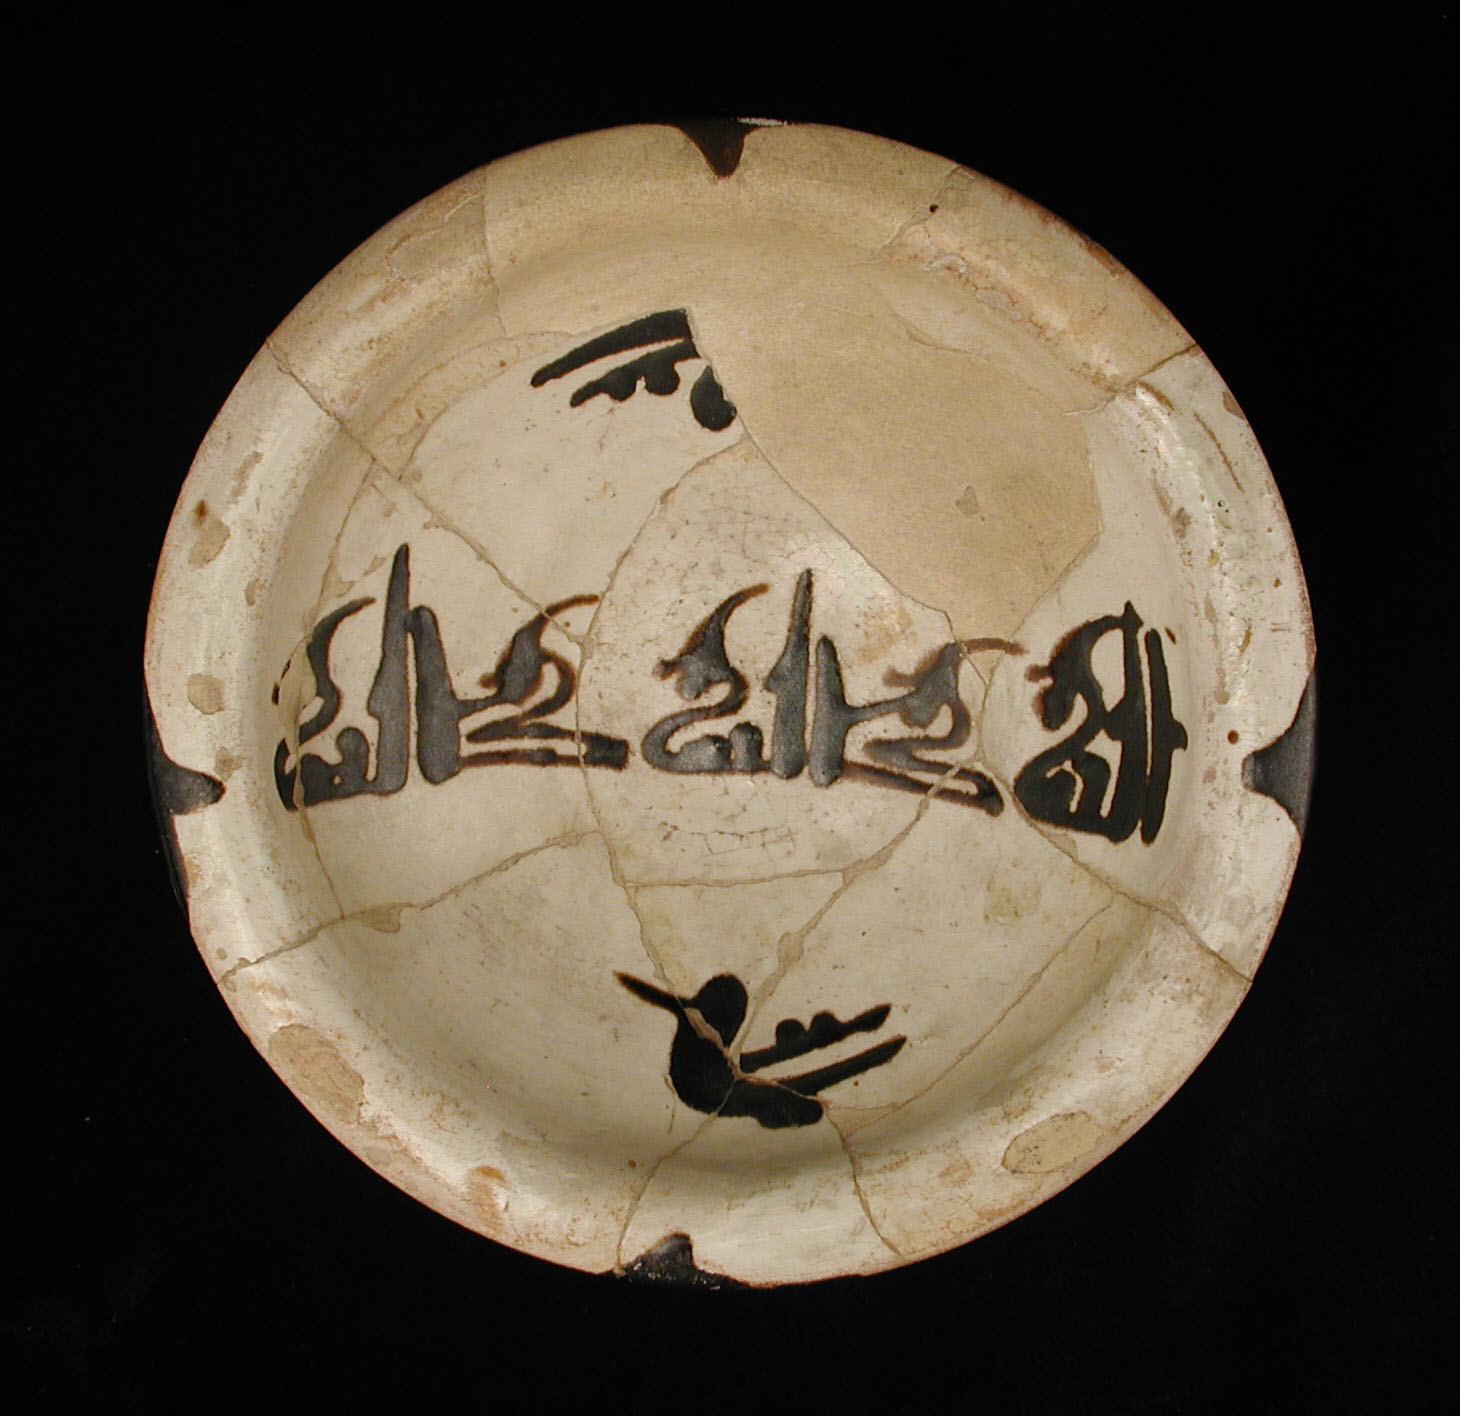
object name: bowl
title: Three Bowls with Floriated Kufic Inscriptions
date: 867-933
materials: earthenware, glaze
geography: iran